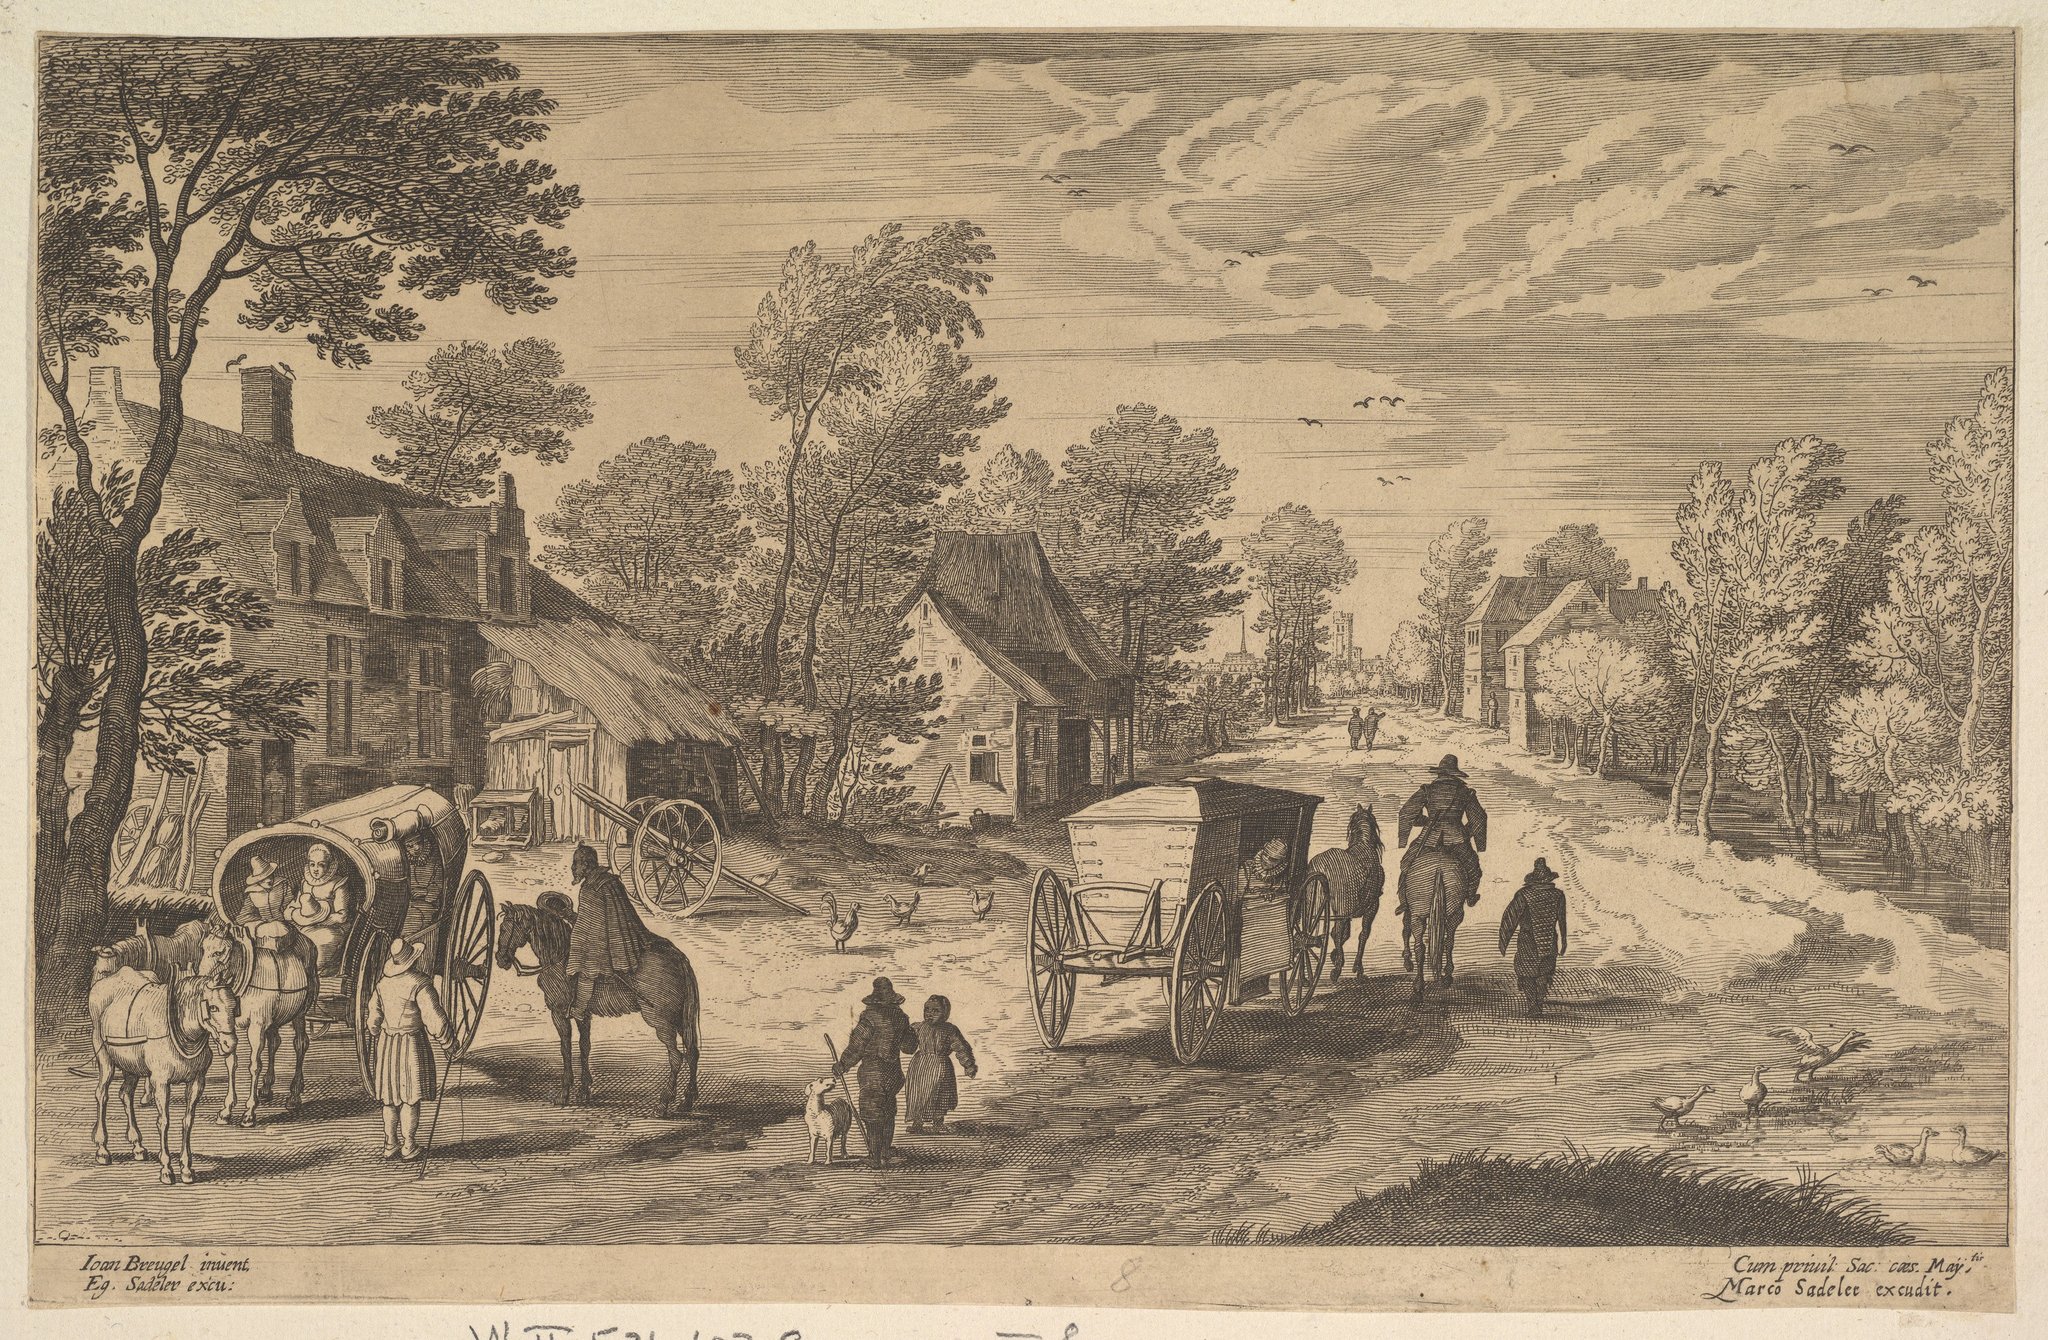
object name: print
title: Village Street with Two Carts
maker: aegidius sadeler (ii)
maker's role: artist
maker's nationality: flemish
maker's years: 1568-1629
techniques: engraving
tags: villages,horses,carts